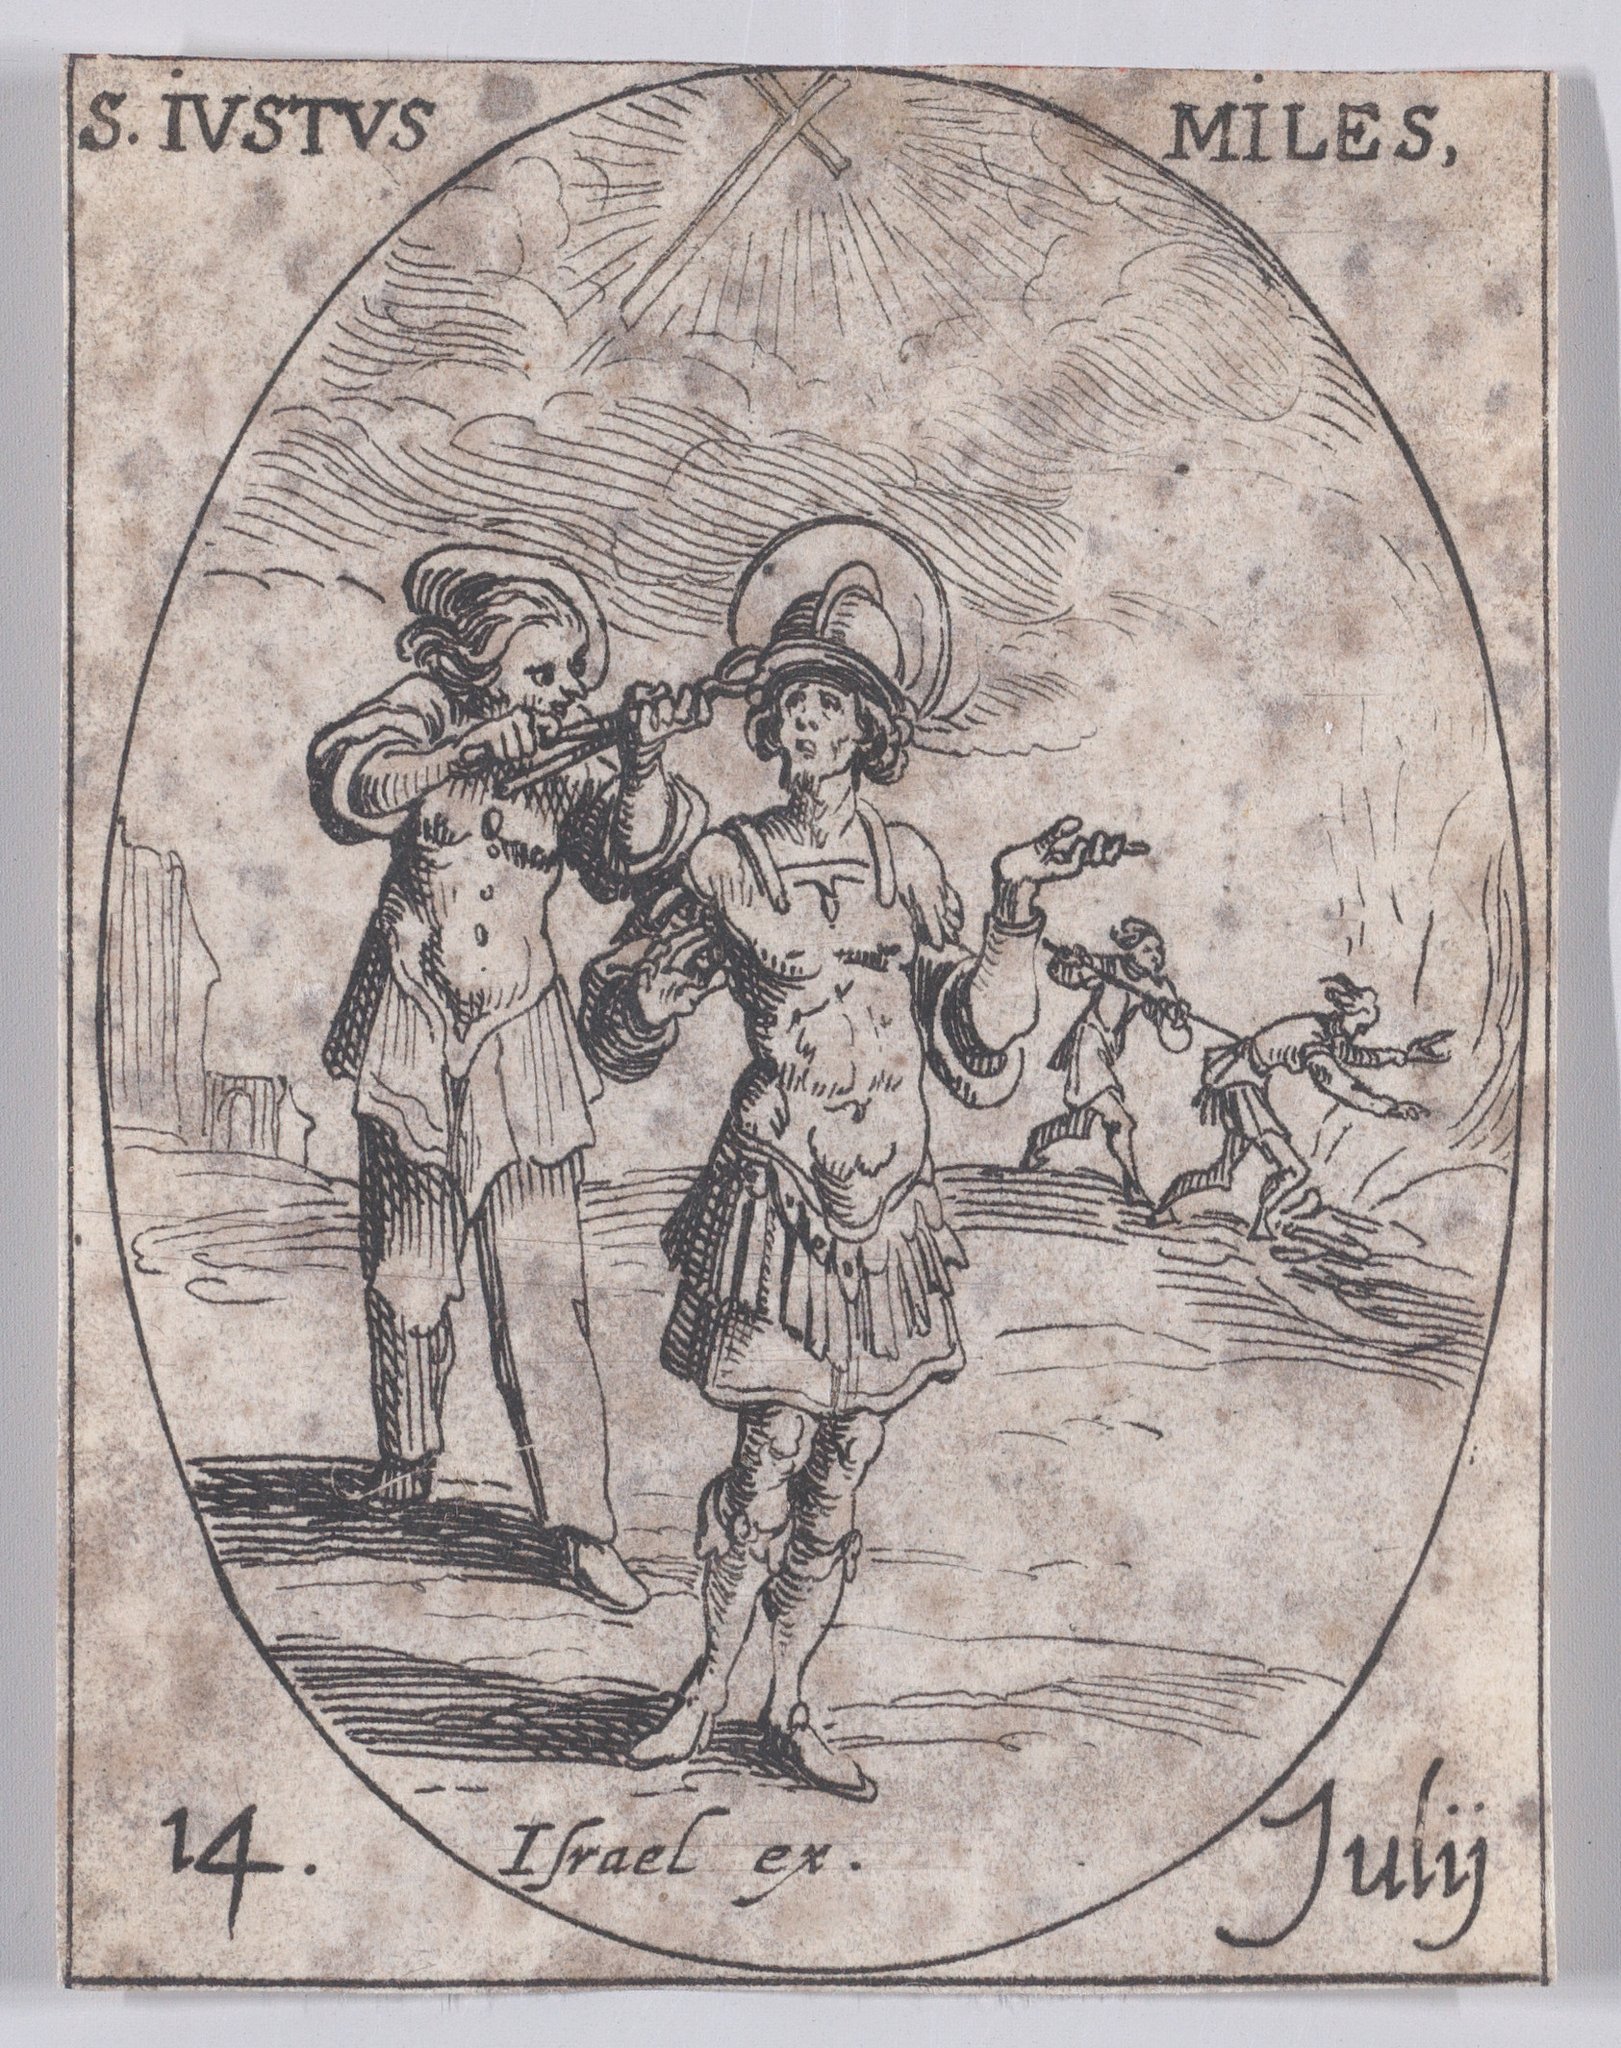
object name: print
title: S. Juste, soldat (St. Justus, Soldier), July 14th, from "Les Images De Tous Les Saincts et Saintes de L'Année" (Images of All of the Saints and Religious Events of the Year)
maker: jacques callot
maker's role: artist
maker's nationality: french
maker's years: 1592-1635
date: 1636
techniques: etching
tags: men,saints